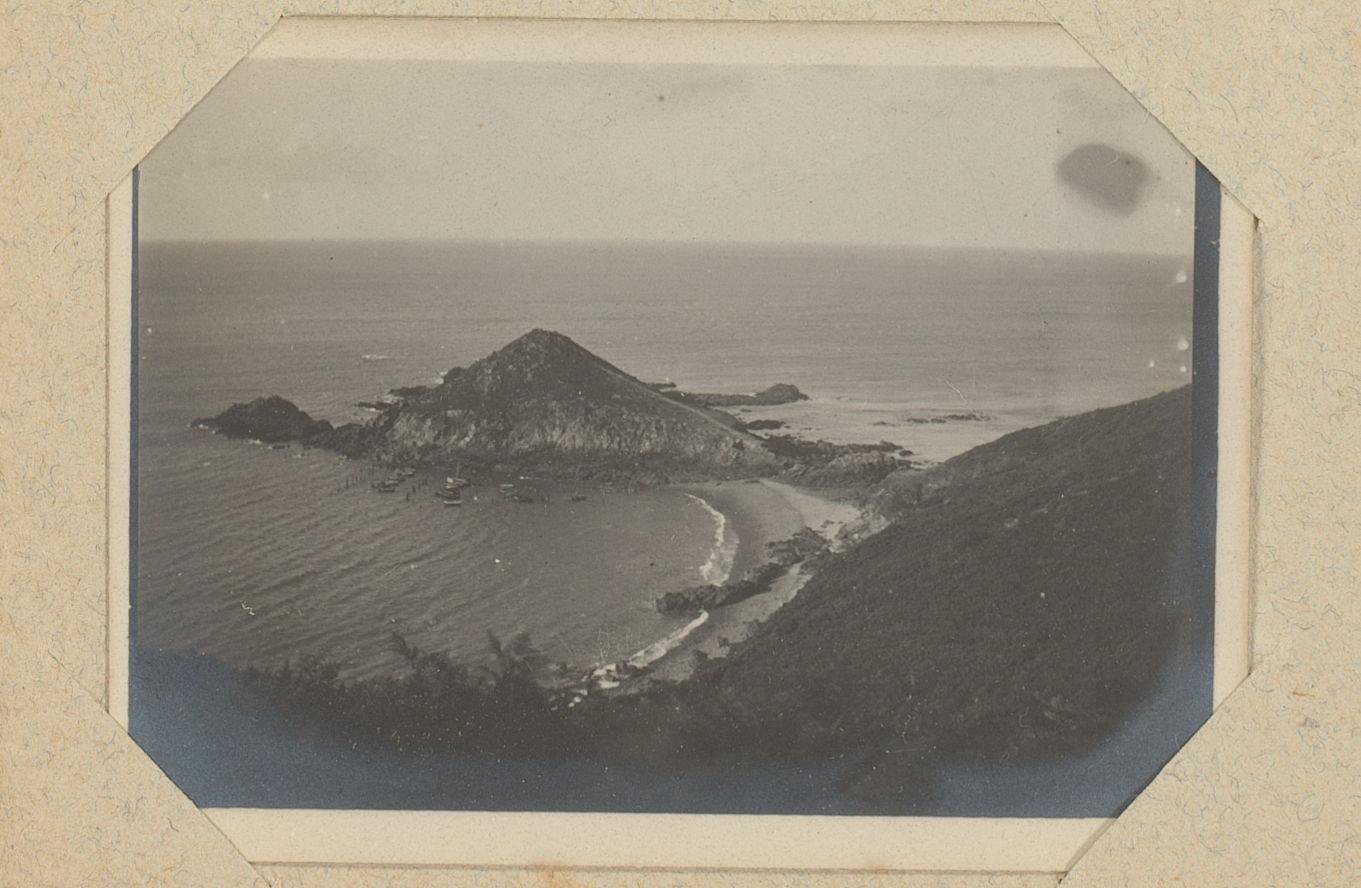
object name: photograph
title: Gezicht op een schiereiland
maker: Anonymous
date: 1897-1900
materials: paper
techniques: gelatin silver print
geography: france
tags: peninsula, france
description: Over de foto is een ander negatief afgedrukt van een voorstelling van bomen.